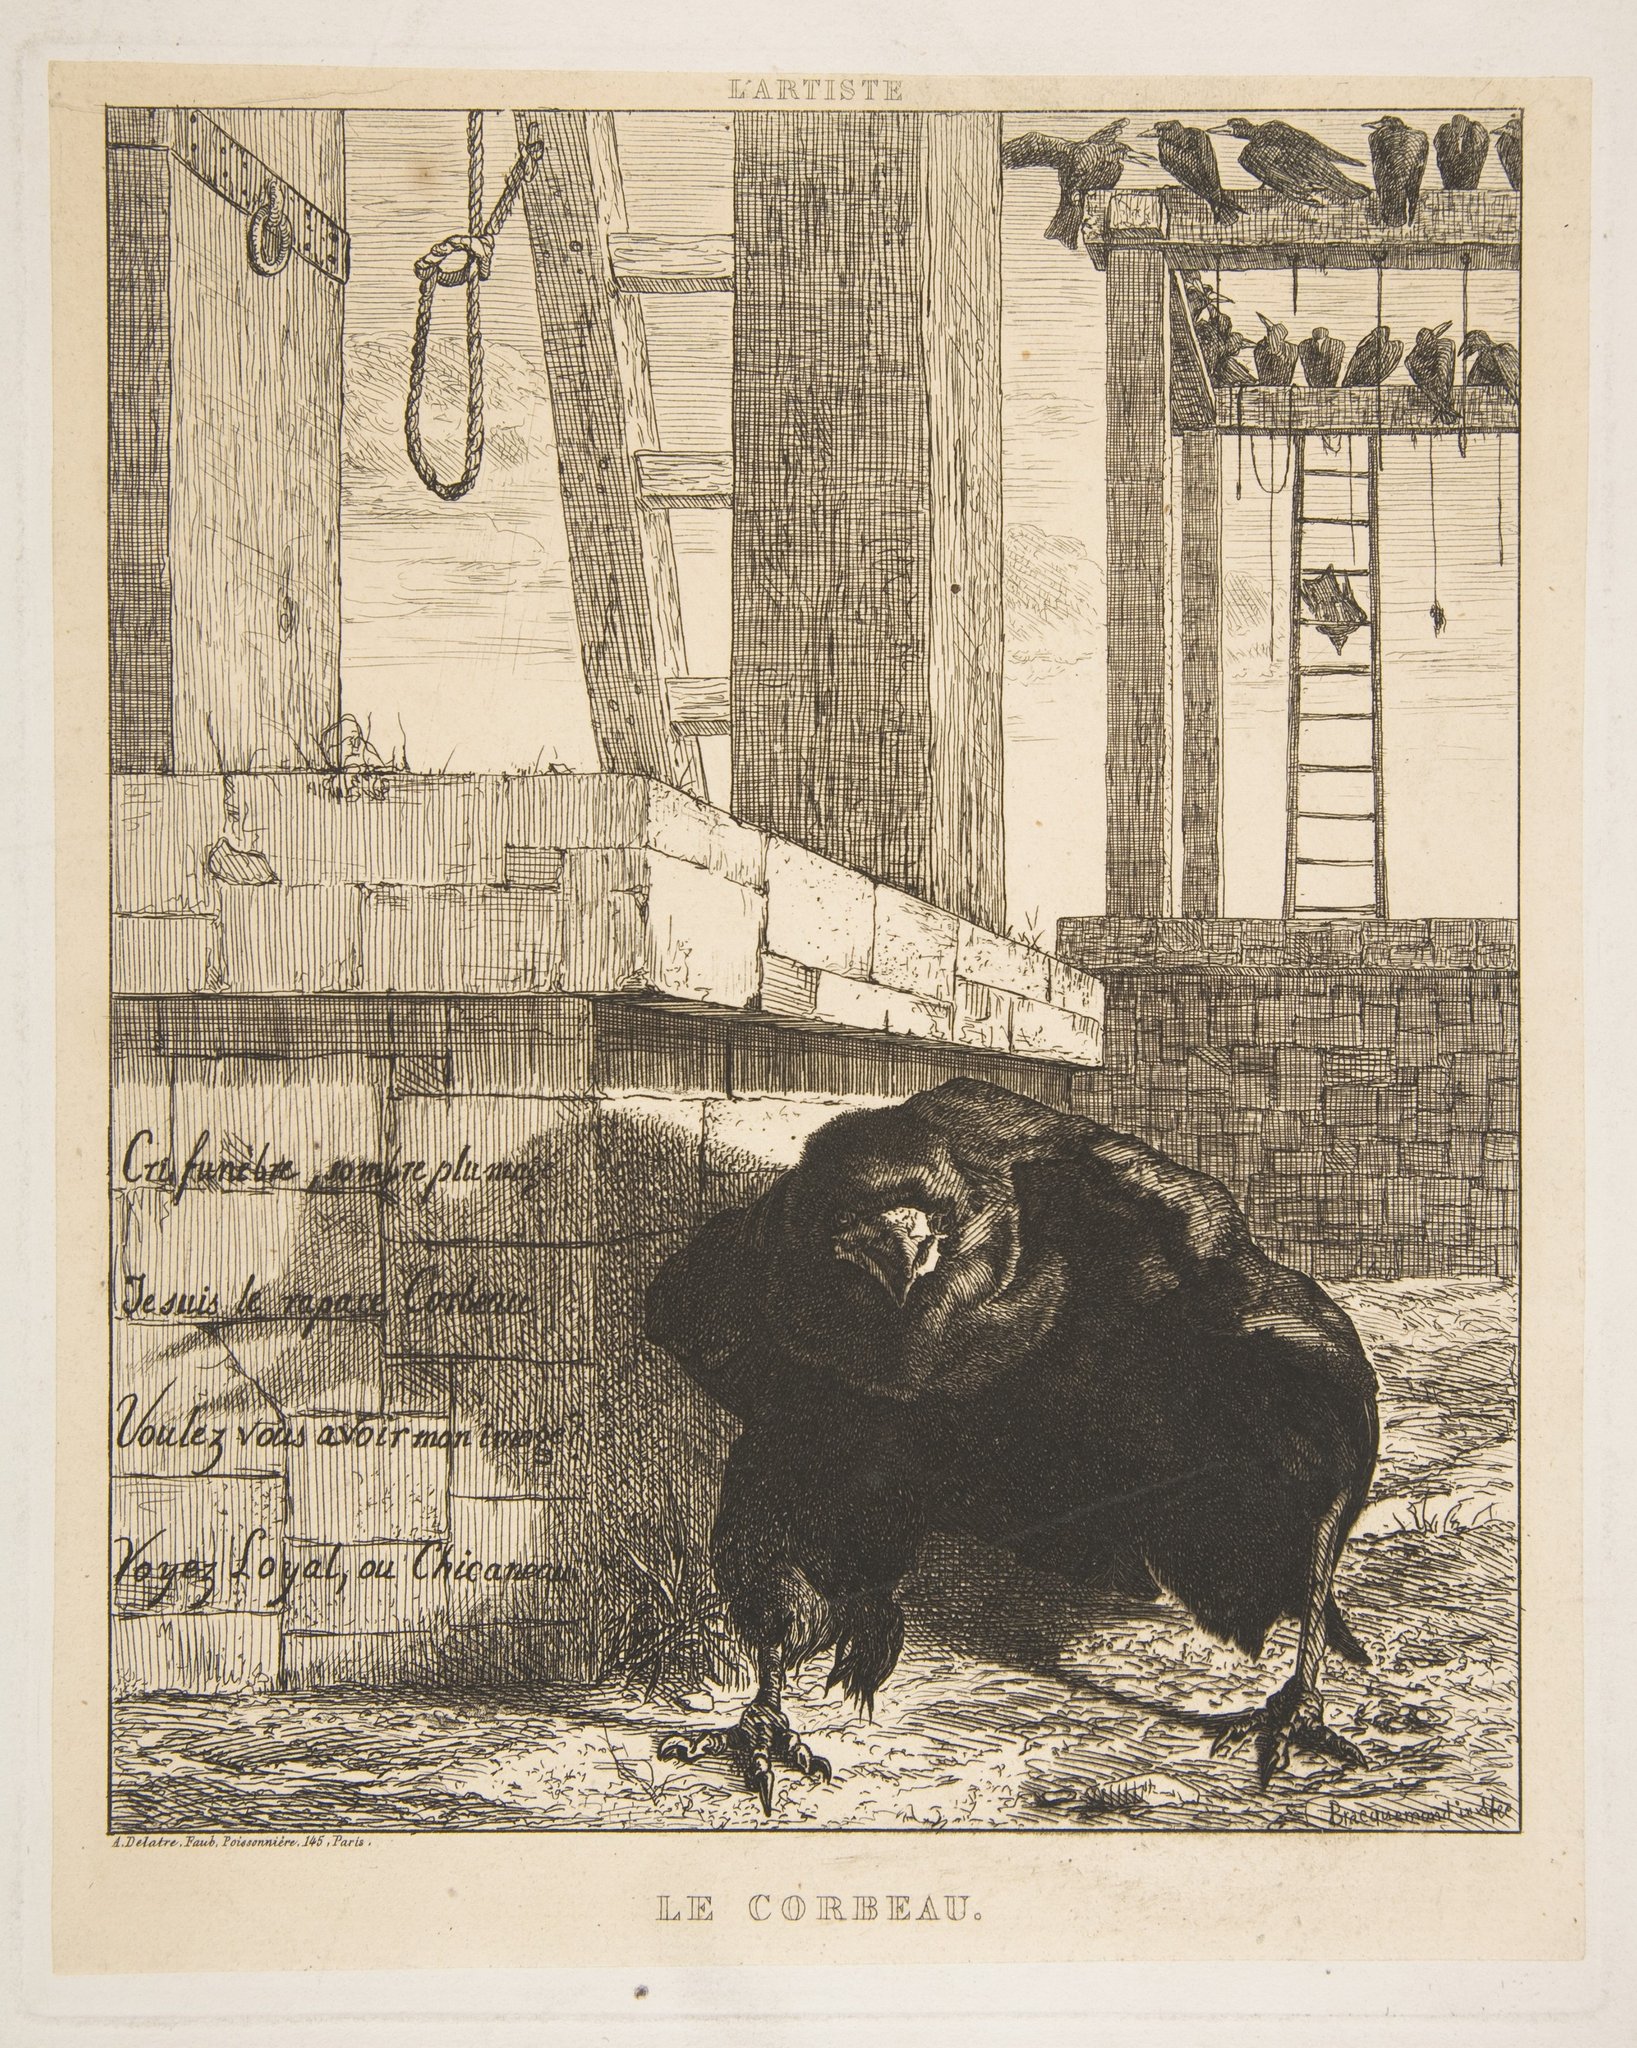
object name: print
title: Le Corbeau, from "L'Artiste"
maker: félix bracquemond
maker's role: artist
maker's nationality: french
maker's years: 1833-1914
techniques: printmaking, etching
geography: france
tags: birds